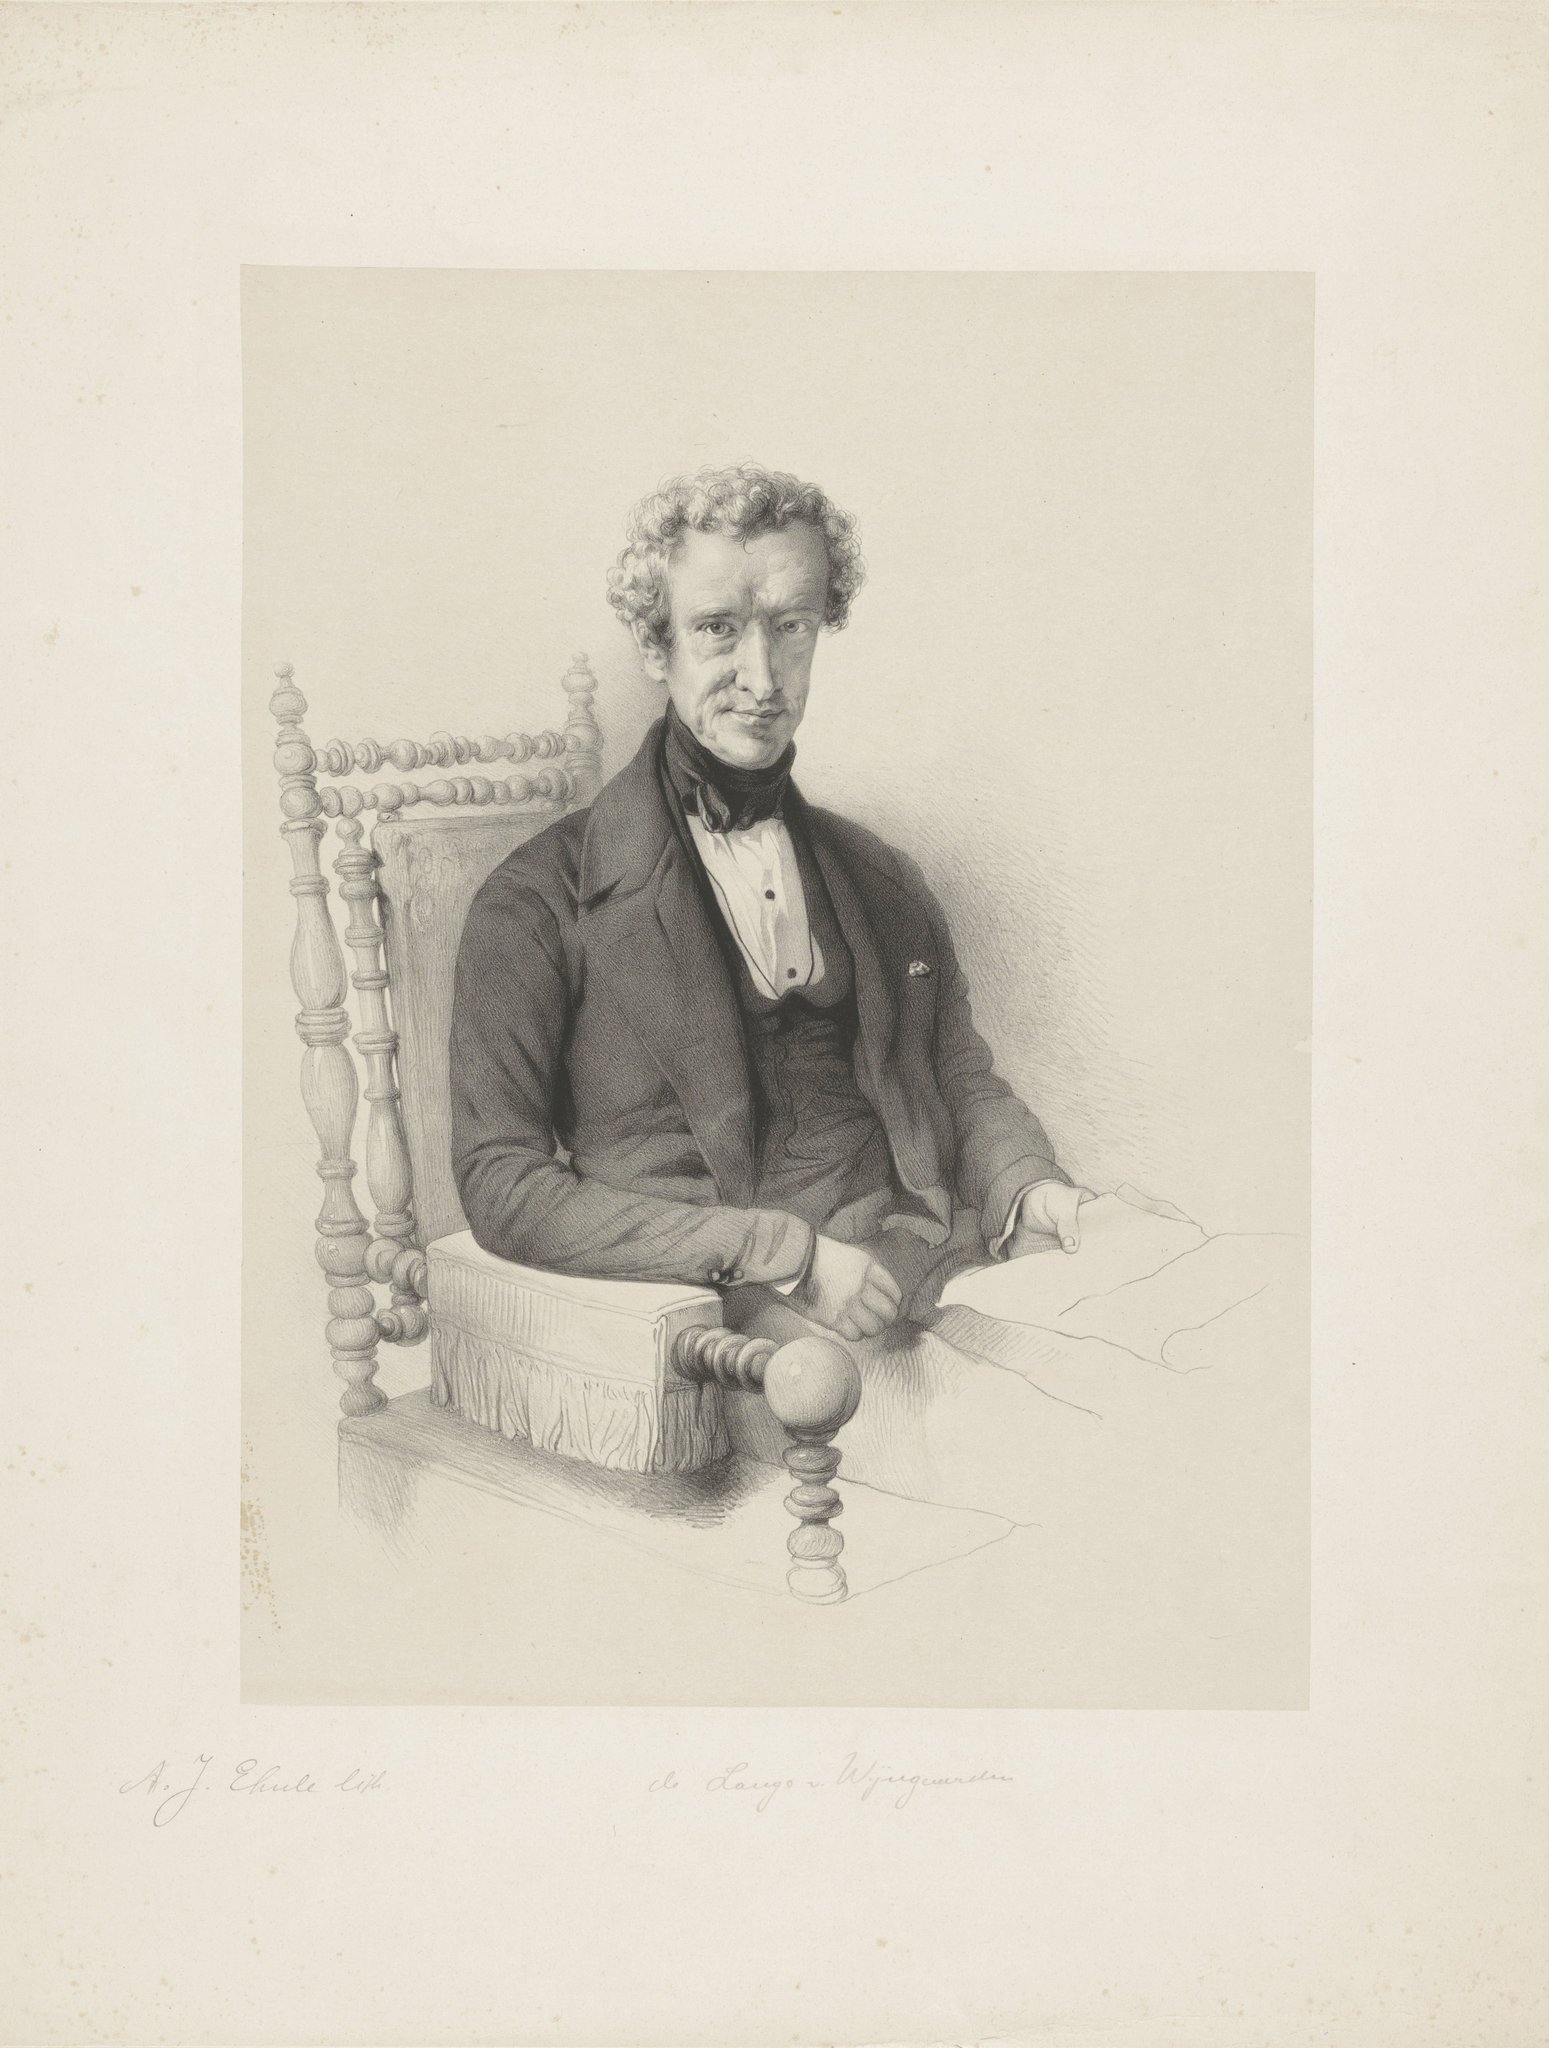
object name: print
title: Portret van Cornelis Johan de Lange van Wijngaarden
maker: adrianus johannes ehnle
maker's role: draughtsman, print maker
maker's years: 1819-1863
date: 1829-1863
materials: paper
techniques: lithograph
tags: gouda, paper (writing material), historical persons (+ (full) bust portrait)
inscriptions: collector's mark: Lugt 2228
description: De geportretteerde zit in een leunstoel. In zijn rechterhand heeft hij een vel papier.